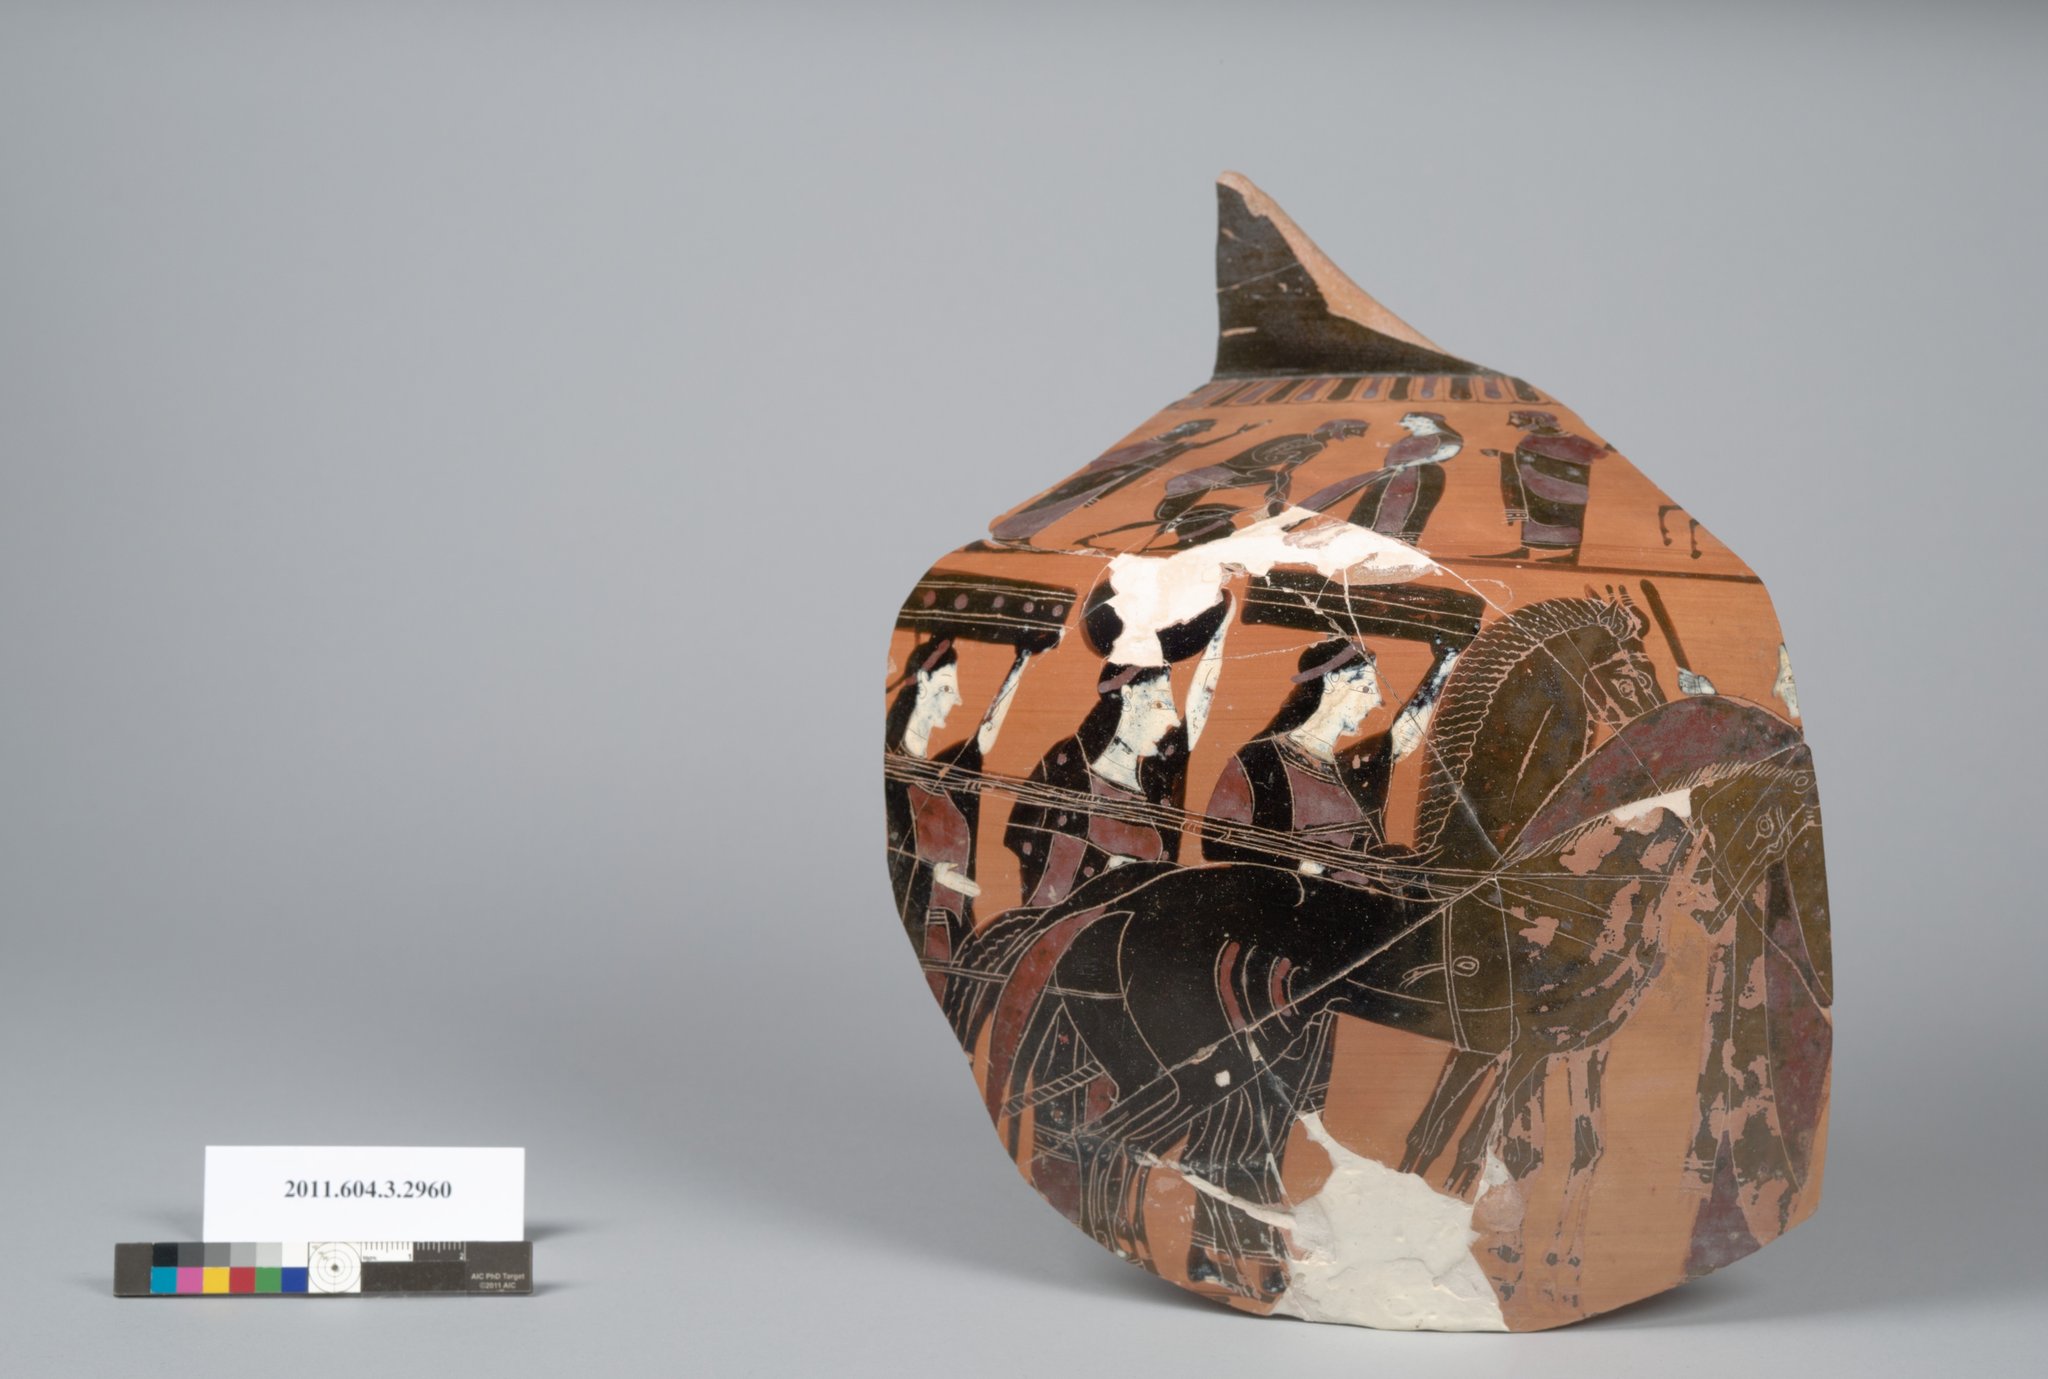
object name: hydria fragment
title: Terracotta fragment of a hydria (water jar)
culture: greek, attic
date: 550-526 BCE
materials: terracotta